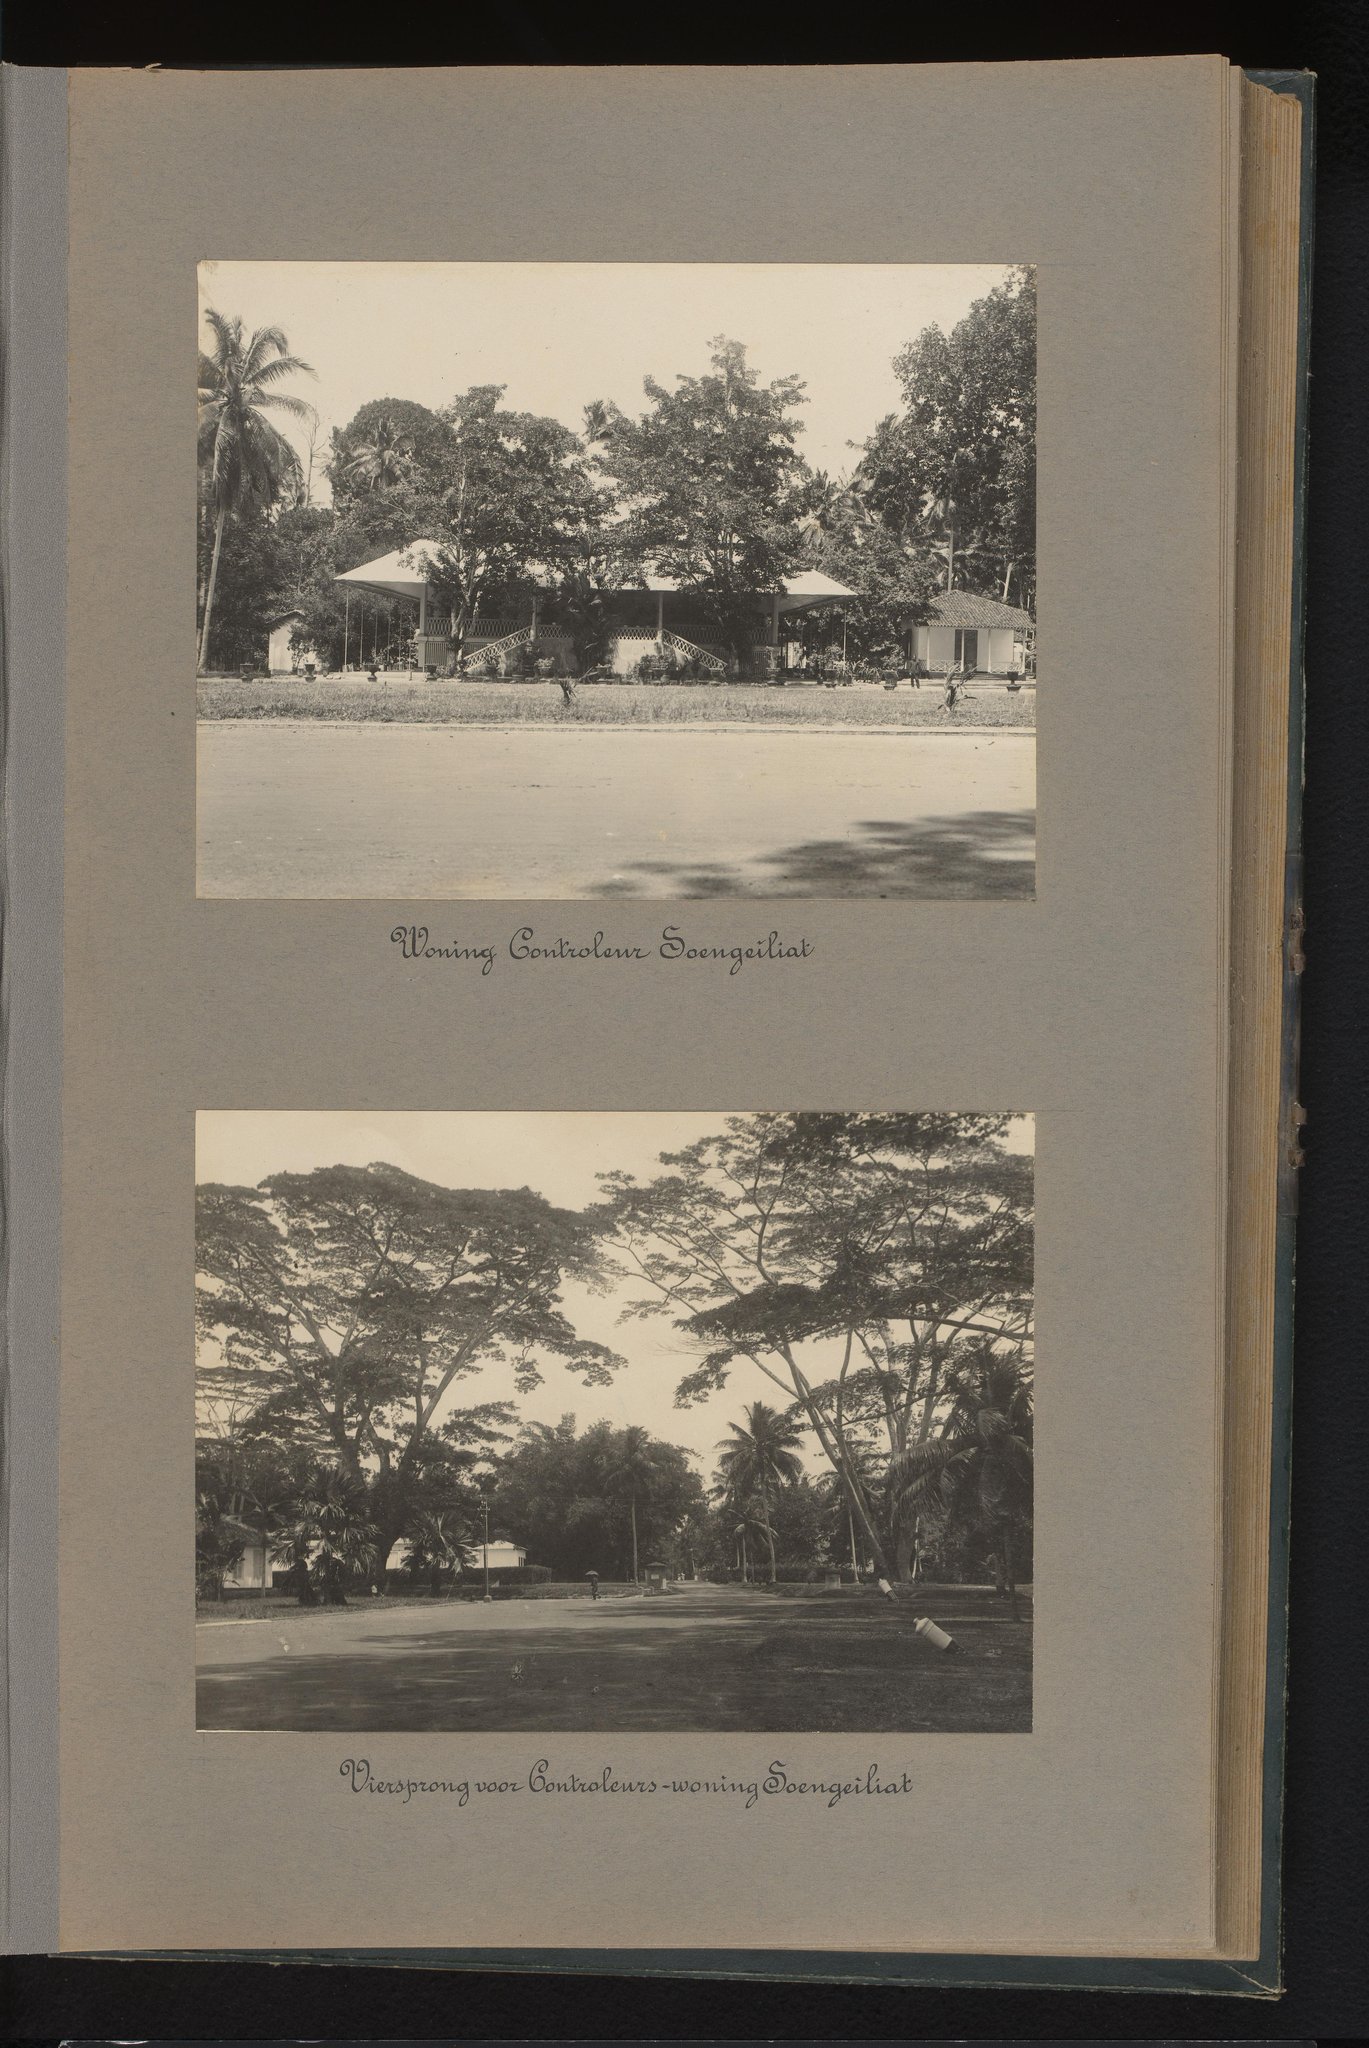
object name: photograph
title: Woningen van controleurs van de Banka-tinwinning te Soengeiliat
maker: Anonymous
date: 1914-1919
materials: cardboard, photographic support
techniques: gelatin silver print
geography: bangka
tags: robert julius boers, colonial system, mining, detached house in city, villa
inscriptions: inscription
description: Albumblad met 2 foto's van woningen van controleurs van de Banka-tinwinning te Soengeiliat. Onderdeel van het fotoalbum aangeboden aan Robert Julius Boers bij zijn vertrek naar Nederland in 1919 door het personeel van de Banka-tinwinning.